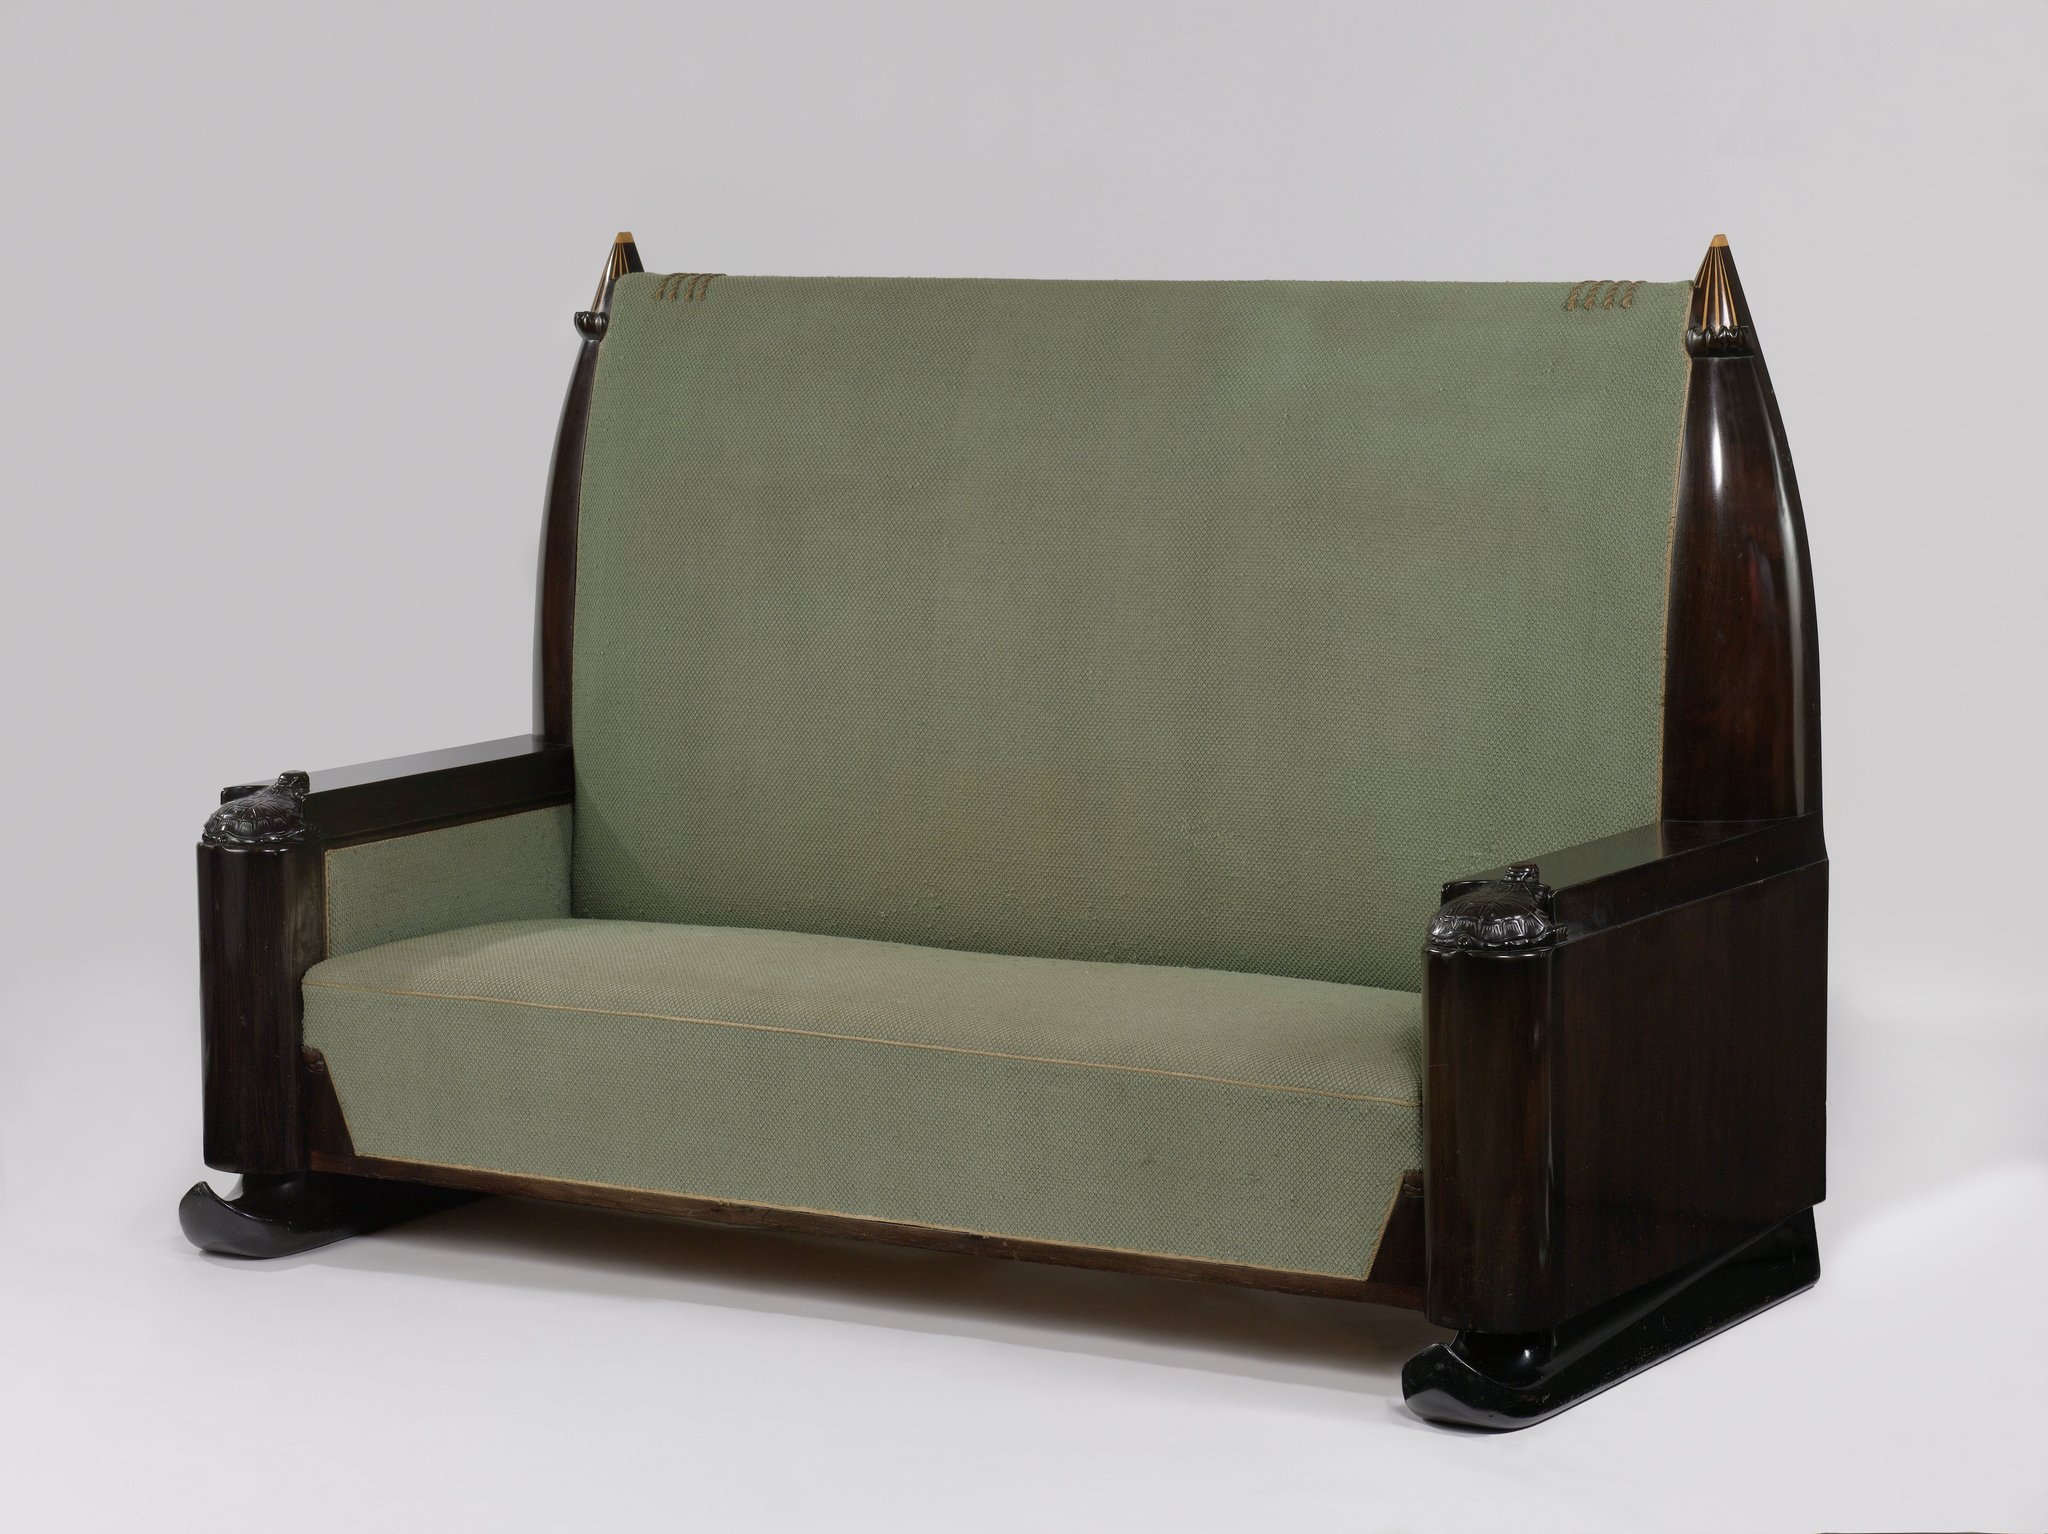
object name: sofa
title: Suite of furniture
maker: michel de klerk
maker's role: painter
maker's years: 1884-1923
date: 1917-1918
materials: wood, textile, wool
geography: amsterdam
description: Michel de Klerk was the leading representative of the Amsterdam School, a movement in architecture and decorative art in the 1910s and ’20s. As an architect, he designed expressive Modernist buildings. And architectural shapes characterize his furniture designs, which have carved details such as turtles’ and frogs’ heads. The table looks like a massive sculpture. Sledge-shaped feet make it possible to shift the heavy furniture.